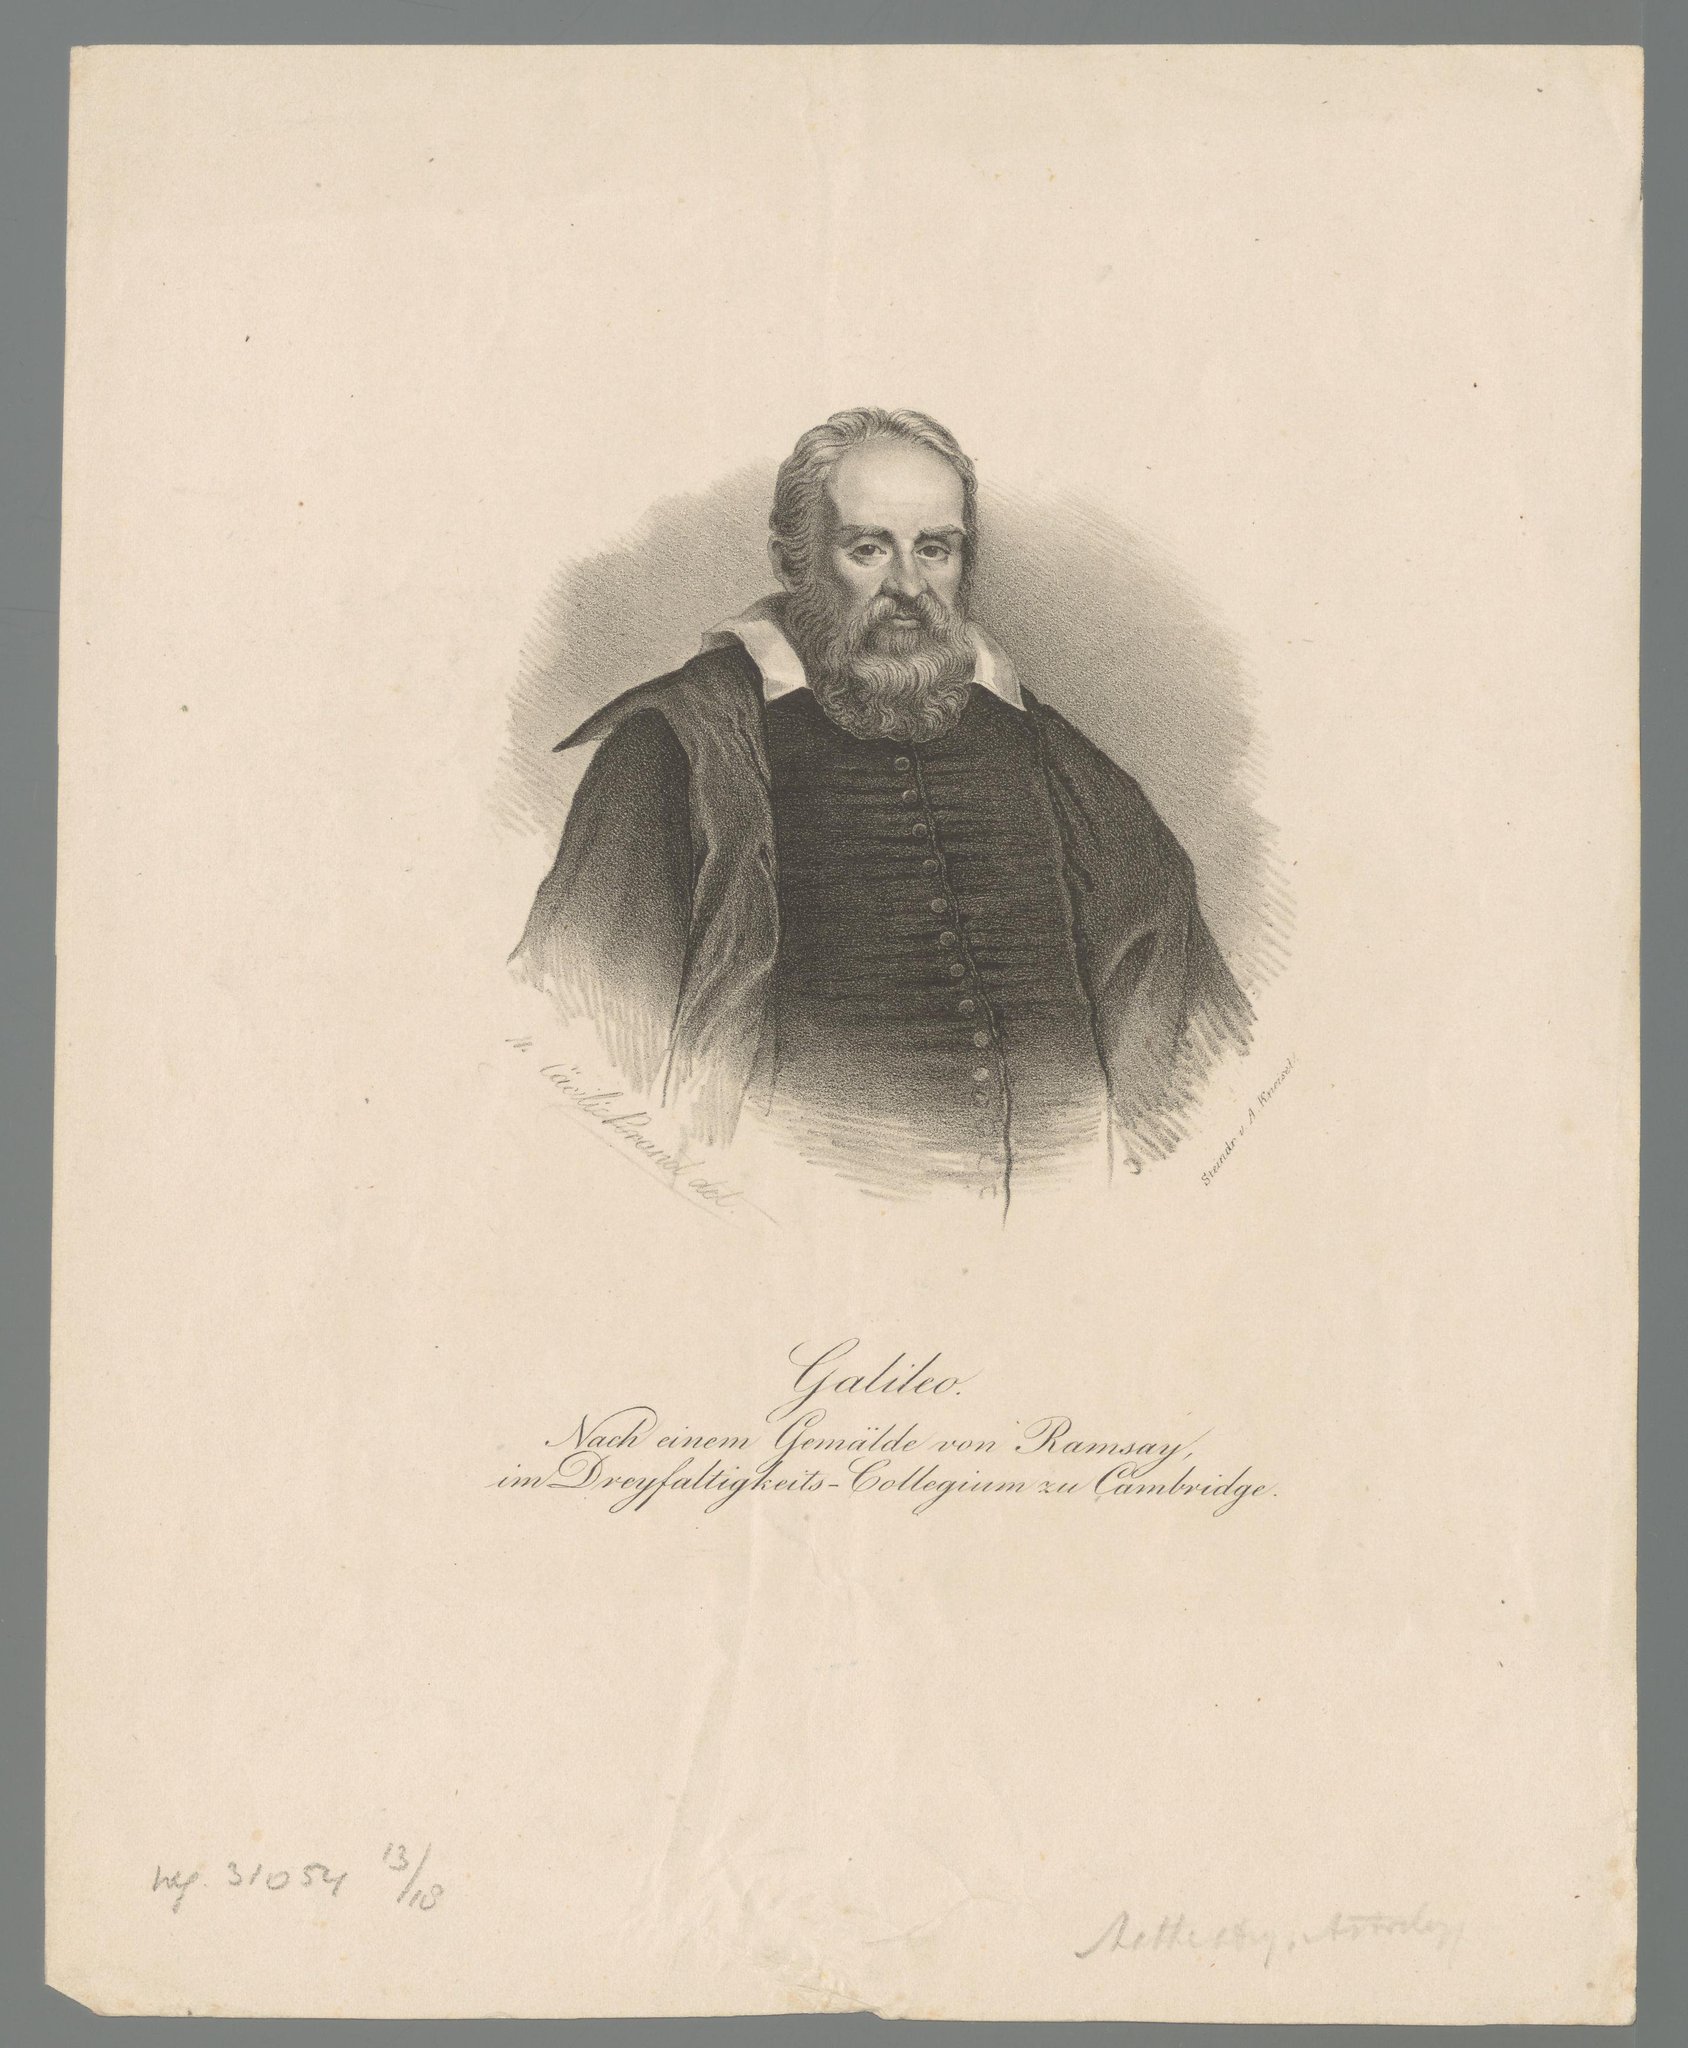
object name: print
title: Galileo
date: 1825-1850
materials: paper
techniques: lithograph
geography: leipzig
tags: draughtsman, physicist, adult man, historical persons, beard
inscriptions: collector's mark: Lugt 2228